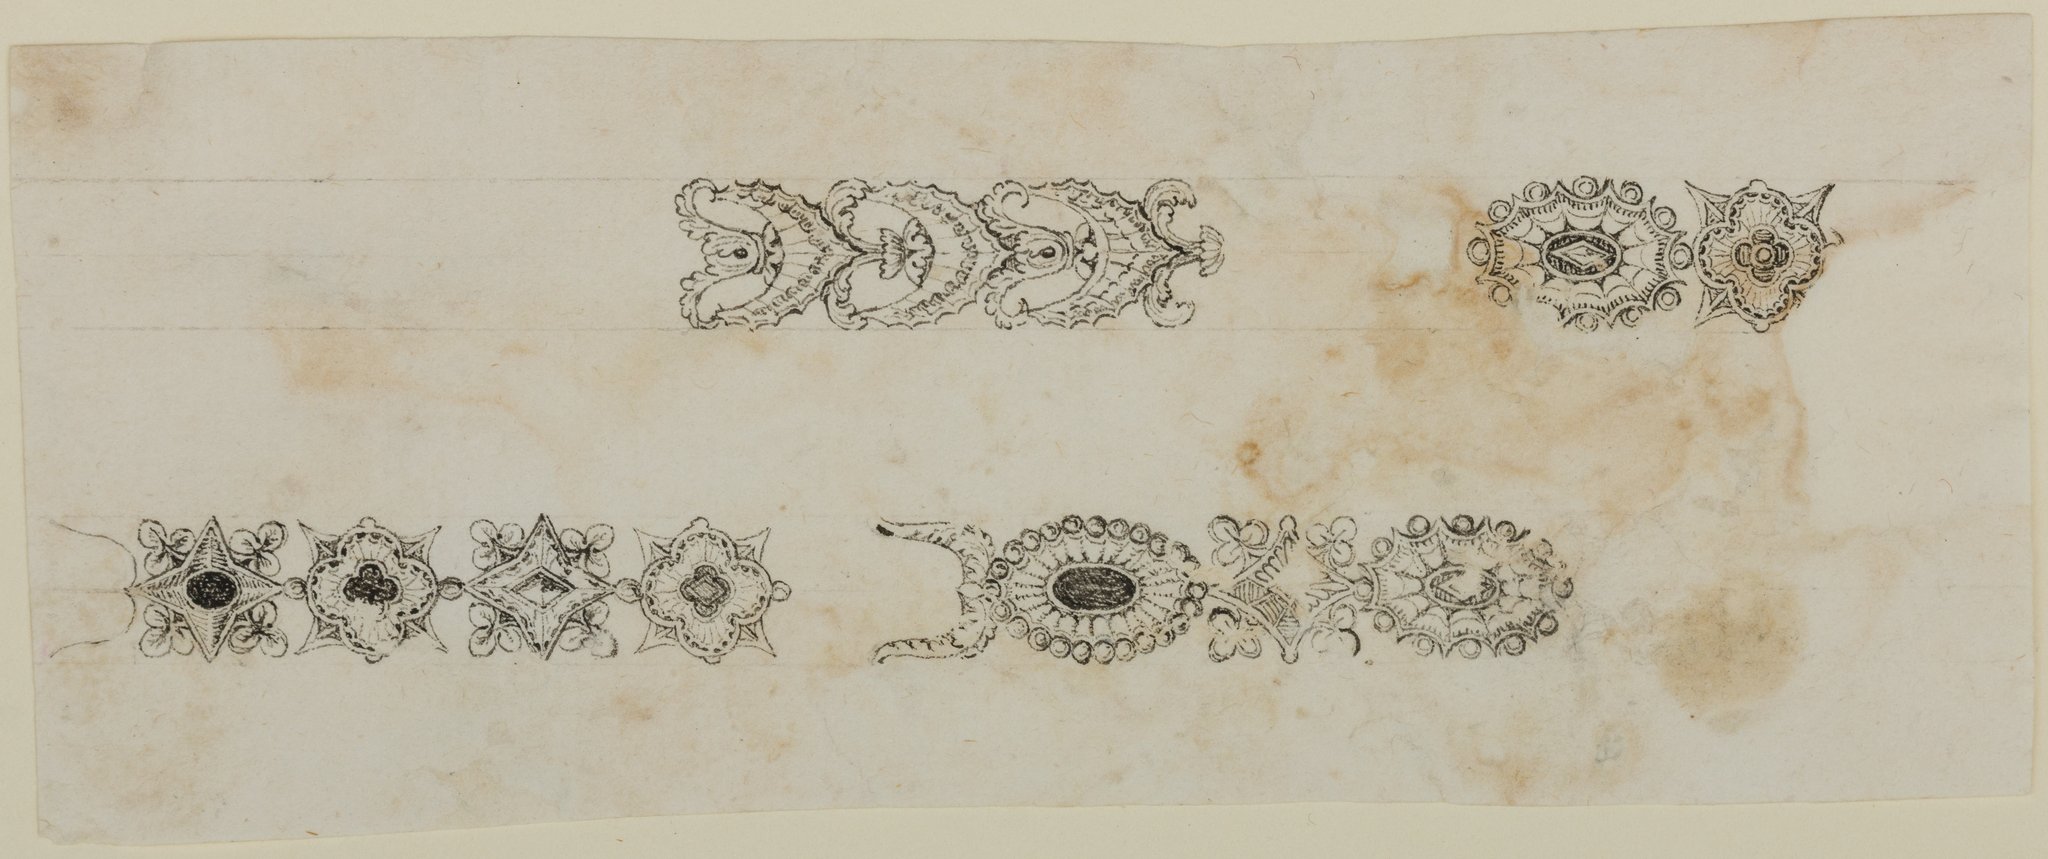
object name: drawing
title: Designs for the Decoration of Firearms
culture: french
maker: nicolas noël boutet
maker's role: designer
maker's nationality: french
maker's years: 1761-1833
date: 1797-1805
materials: ink, paper, pencil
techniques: wash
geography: france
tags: ornament